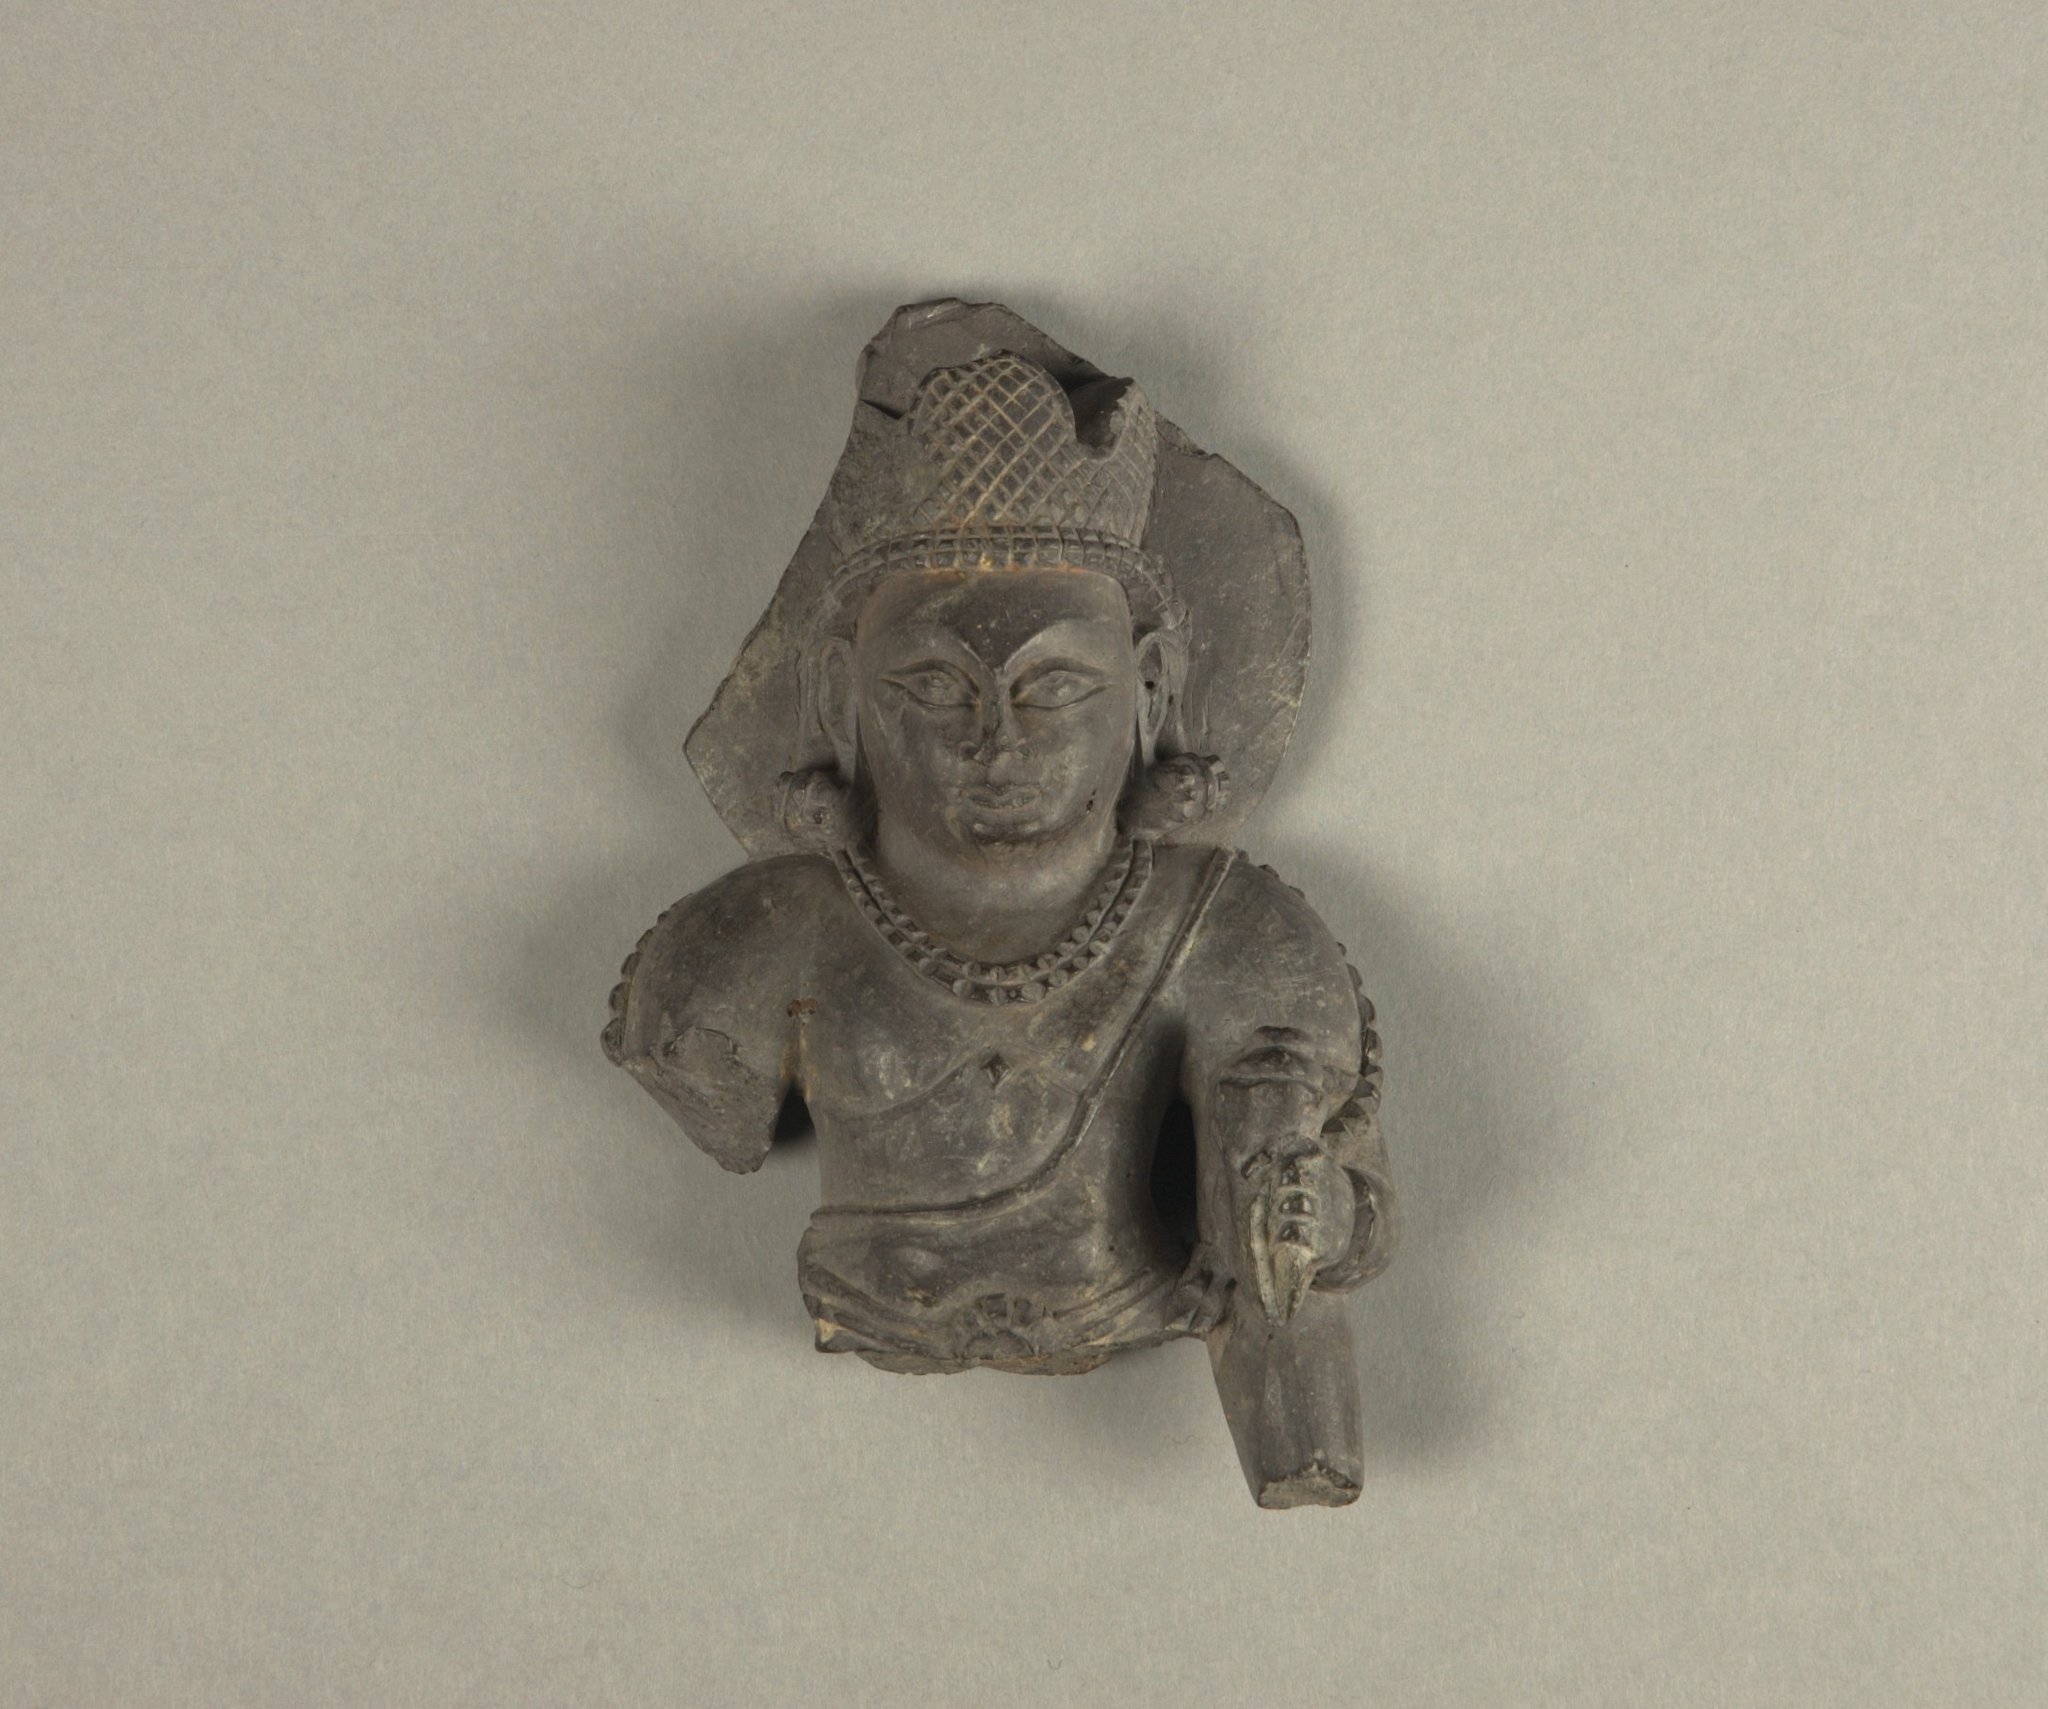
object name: fragment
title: Upper Portion and Head of Vishnu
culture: kashmiri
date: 501-700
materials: stone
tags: kashmir,heads,vishnu,hinduism